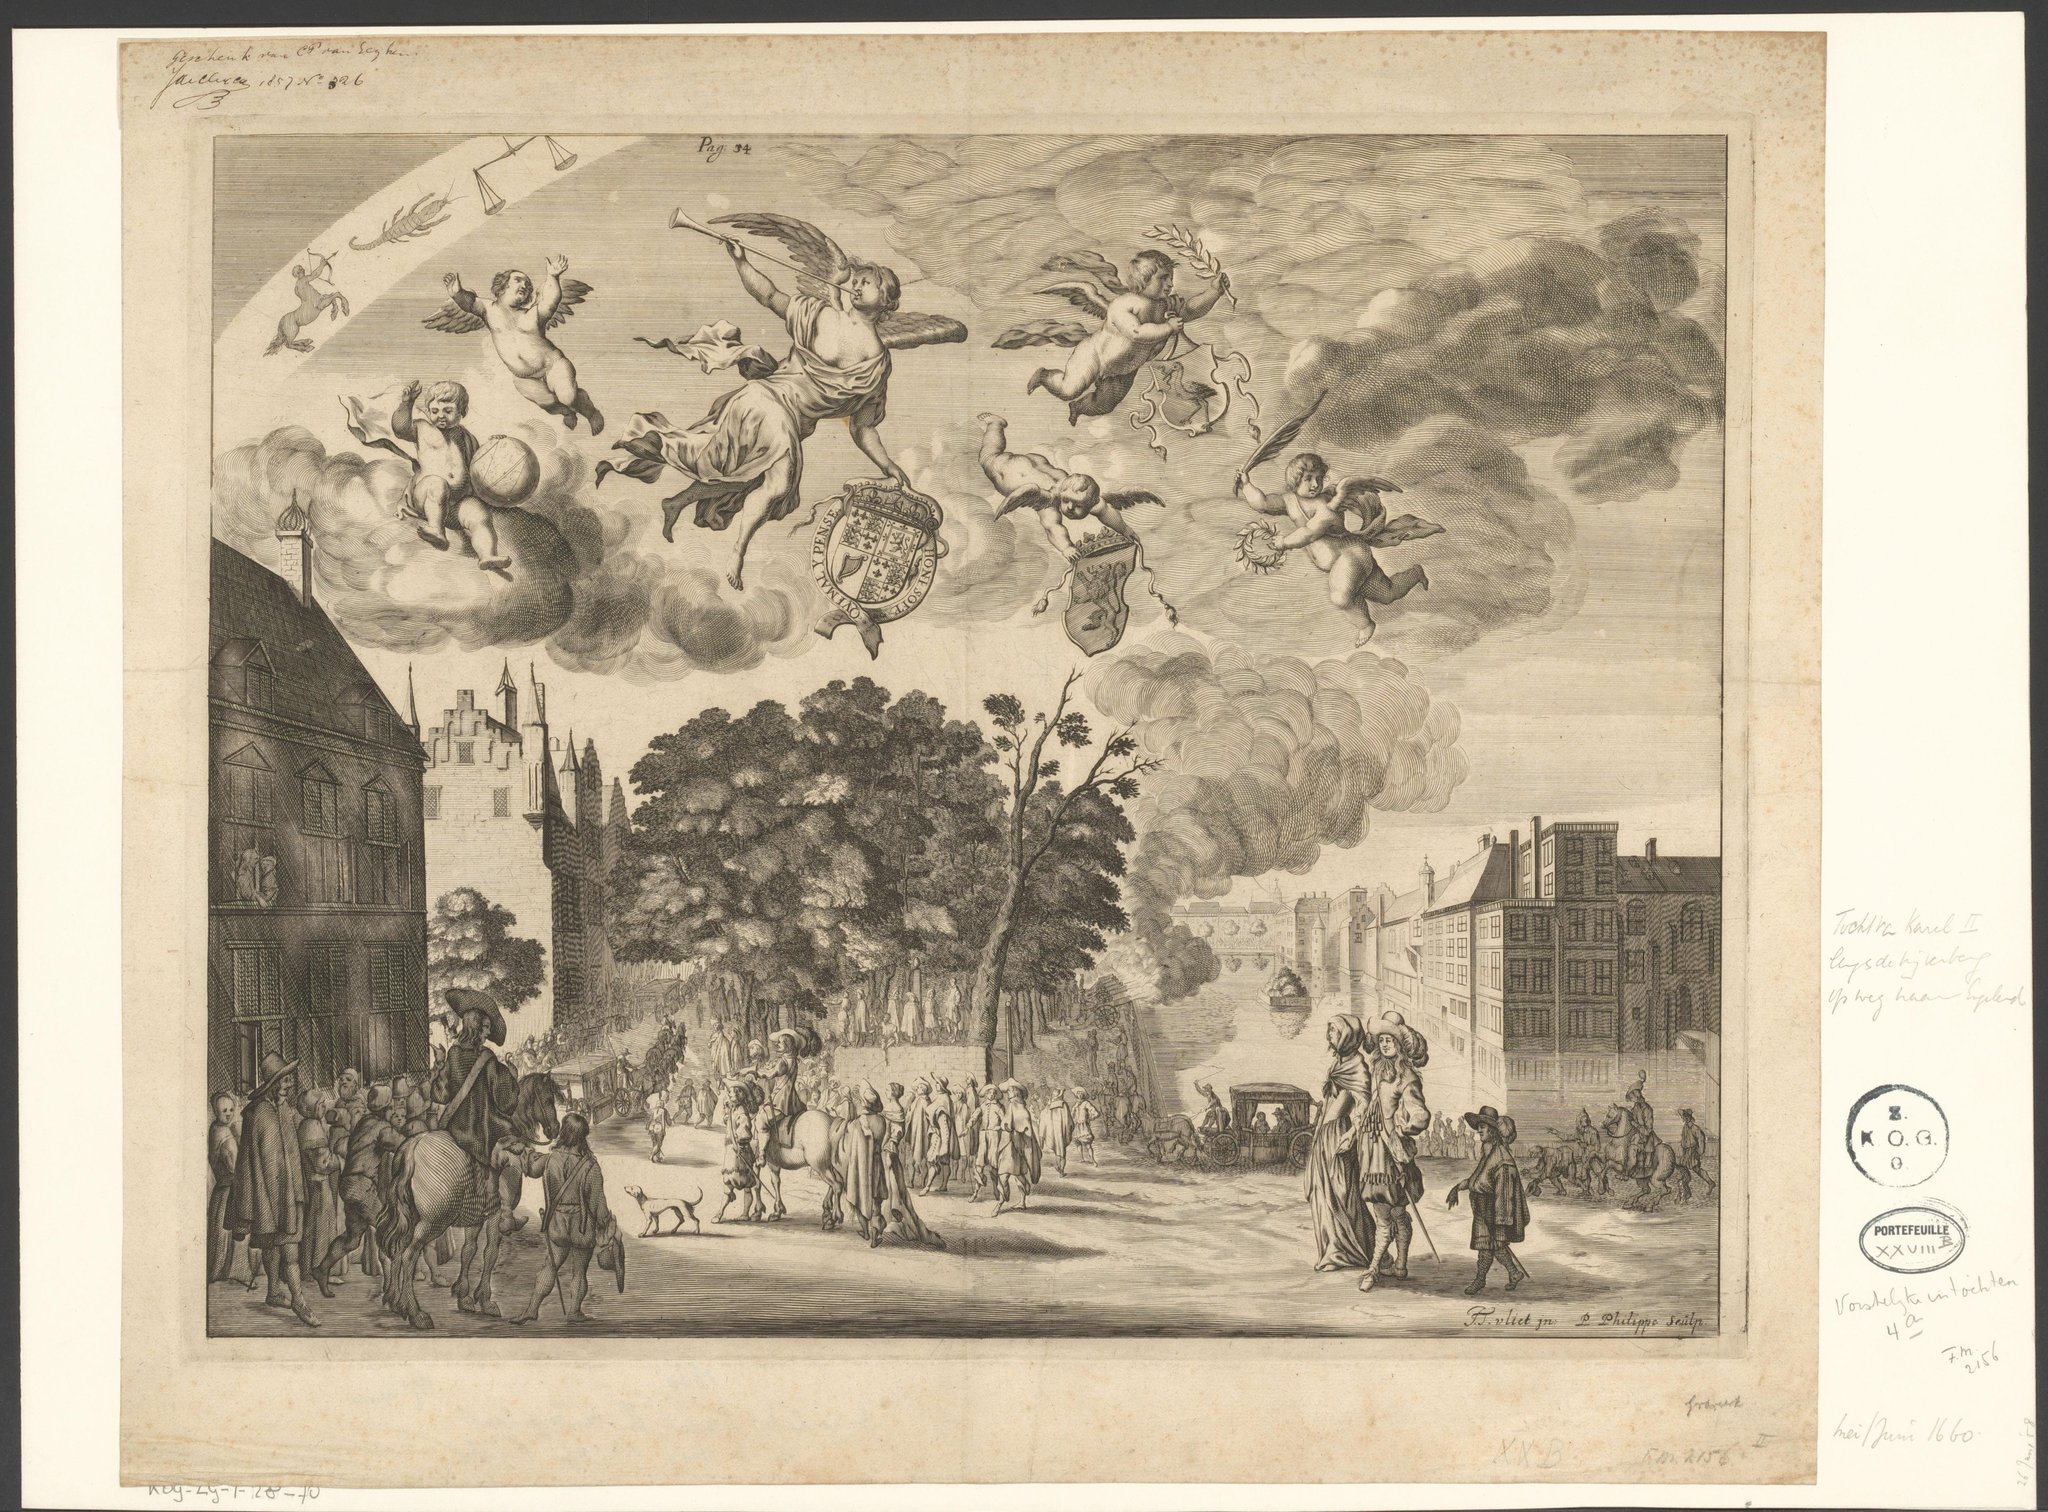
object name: print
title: Aankomst van koning Karel II van Engeland te Den Haag, 1660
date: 1660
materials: paper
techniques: engraving, etching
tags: karel ii (koning van engeland), triumphal entry and public reception, pageant, 'entrée solennelle', 'joyeuse entrée'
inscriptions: stamp, collector's mark: Lugt 1641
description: Aankomst van de Engelse koning Karel II vanuit Delft in Den Haag, 25 mei 1660. Episode tijdens zijn rondreis door en vertrek uit de Nederlanden. Aankomst bij de Vijverberg en het Groene Zoodje, bij de Hofvijver worden saluutschoten afgevuurd. In de lucht de Faam en putti met de wapens van de Engelse koning, Holland en Den Haag. Links een deel van de tekens van de dierenriem. Bovenaan genummerd: Pag: 34. Onderwerpsrubrieken binnen de Atlas Zeden en Gewoonten: Zeden en Gewoonten in Engeren Zin. Volksleven. Openbare feesten. Vorstelijke intochten, (Illuminaties, vuurwerken en dergelijke, openbare feesten).